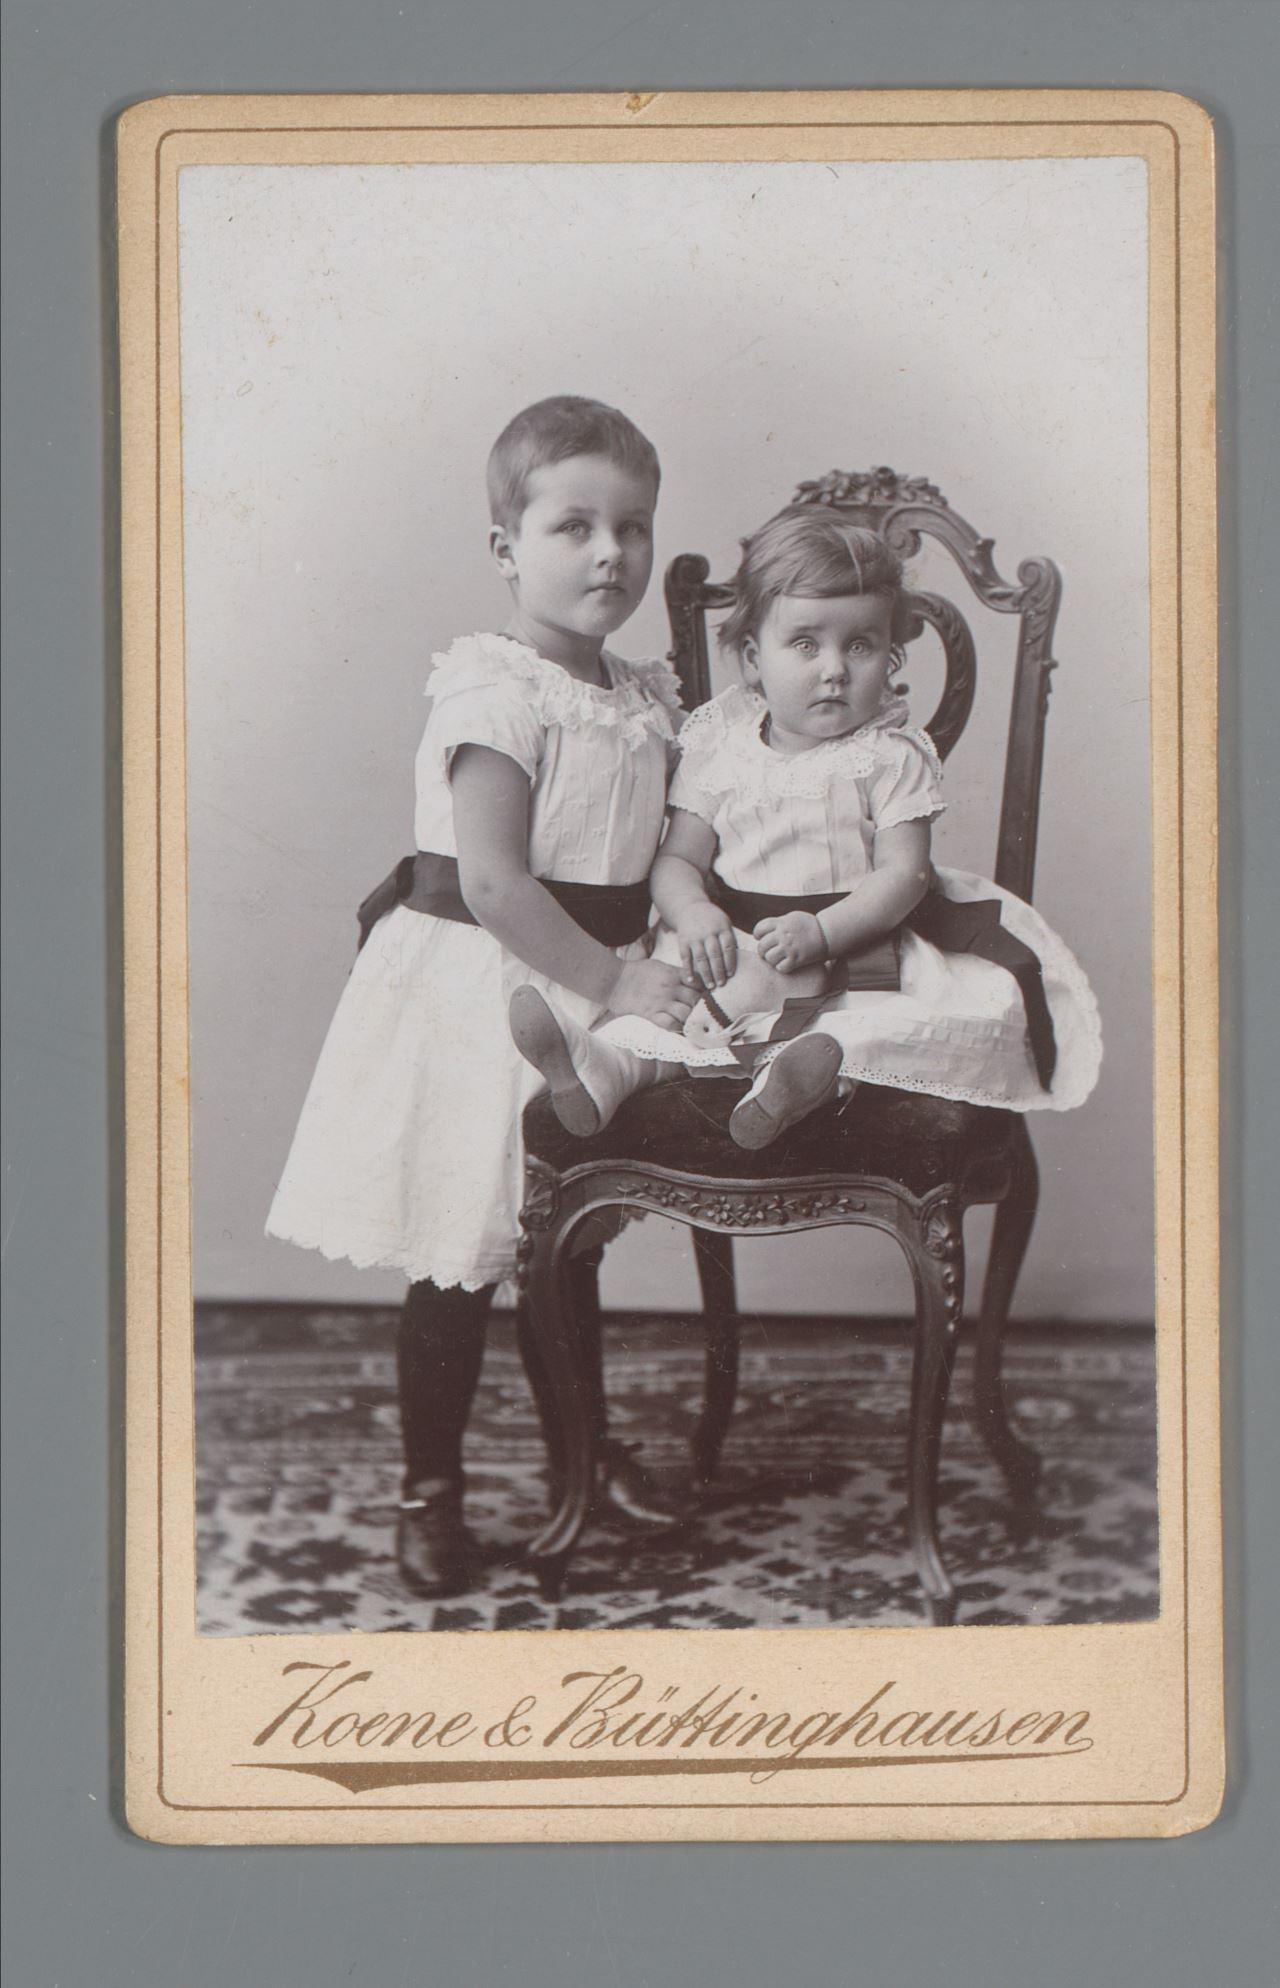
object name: photograph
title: Portret van Willem Jonker en Johanna Geertruida Jonker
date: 1899-1900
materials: cardboard, photographic support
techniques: collodion silver print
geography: amsterdam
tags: historical persons, amsterdam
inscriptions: workshop stamp: ‘Koene&Büttinghausen/ Amsterdam, Heerengracht 150/ Batavia’, annotation: ‘Hanje en Willy/ oud 3 1/2 [...] 1 jaar.’